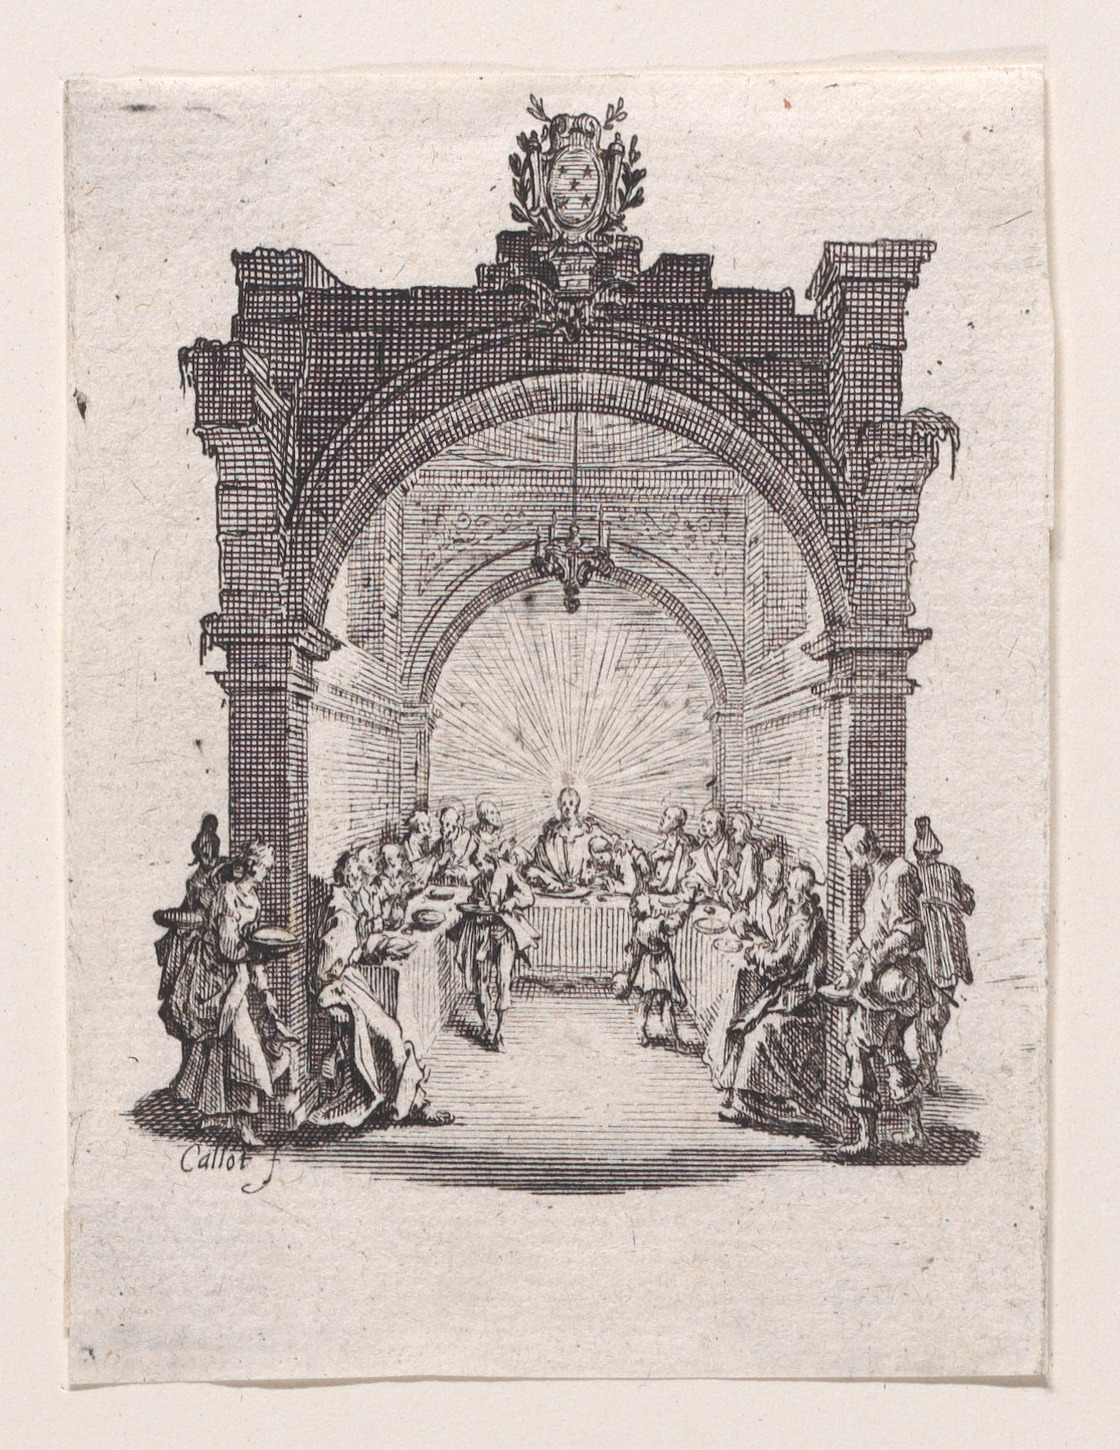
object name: print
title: La Cène (The Last Supper), from "La Petite Passion" (The Little Passion)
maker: jacques callot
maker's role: artist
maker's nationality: french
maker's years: 1592-1635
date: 1624-1625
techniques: etching